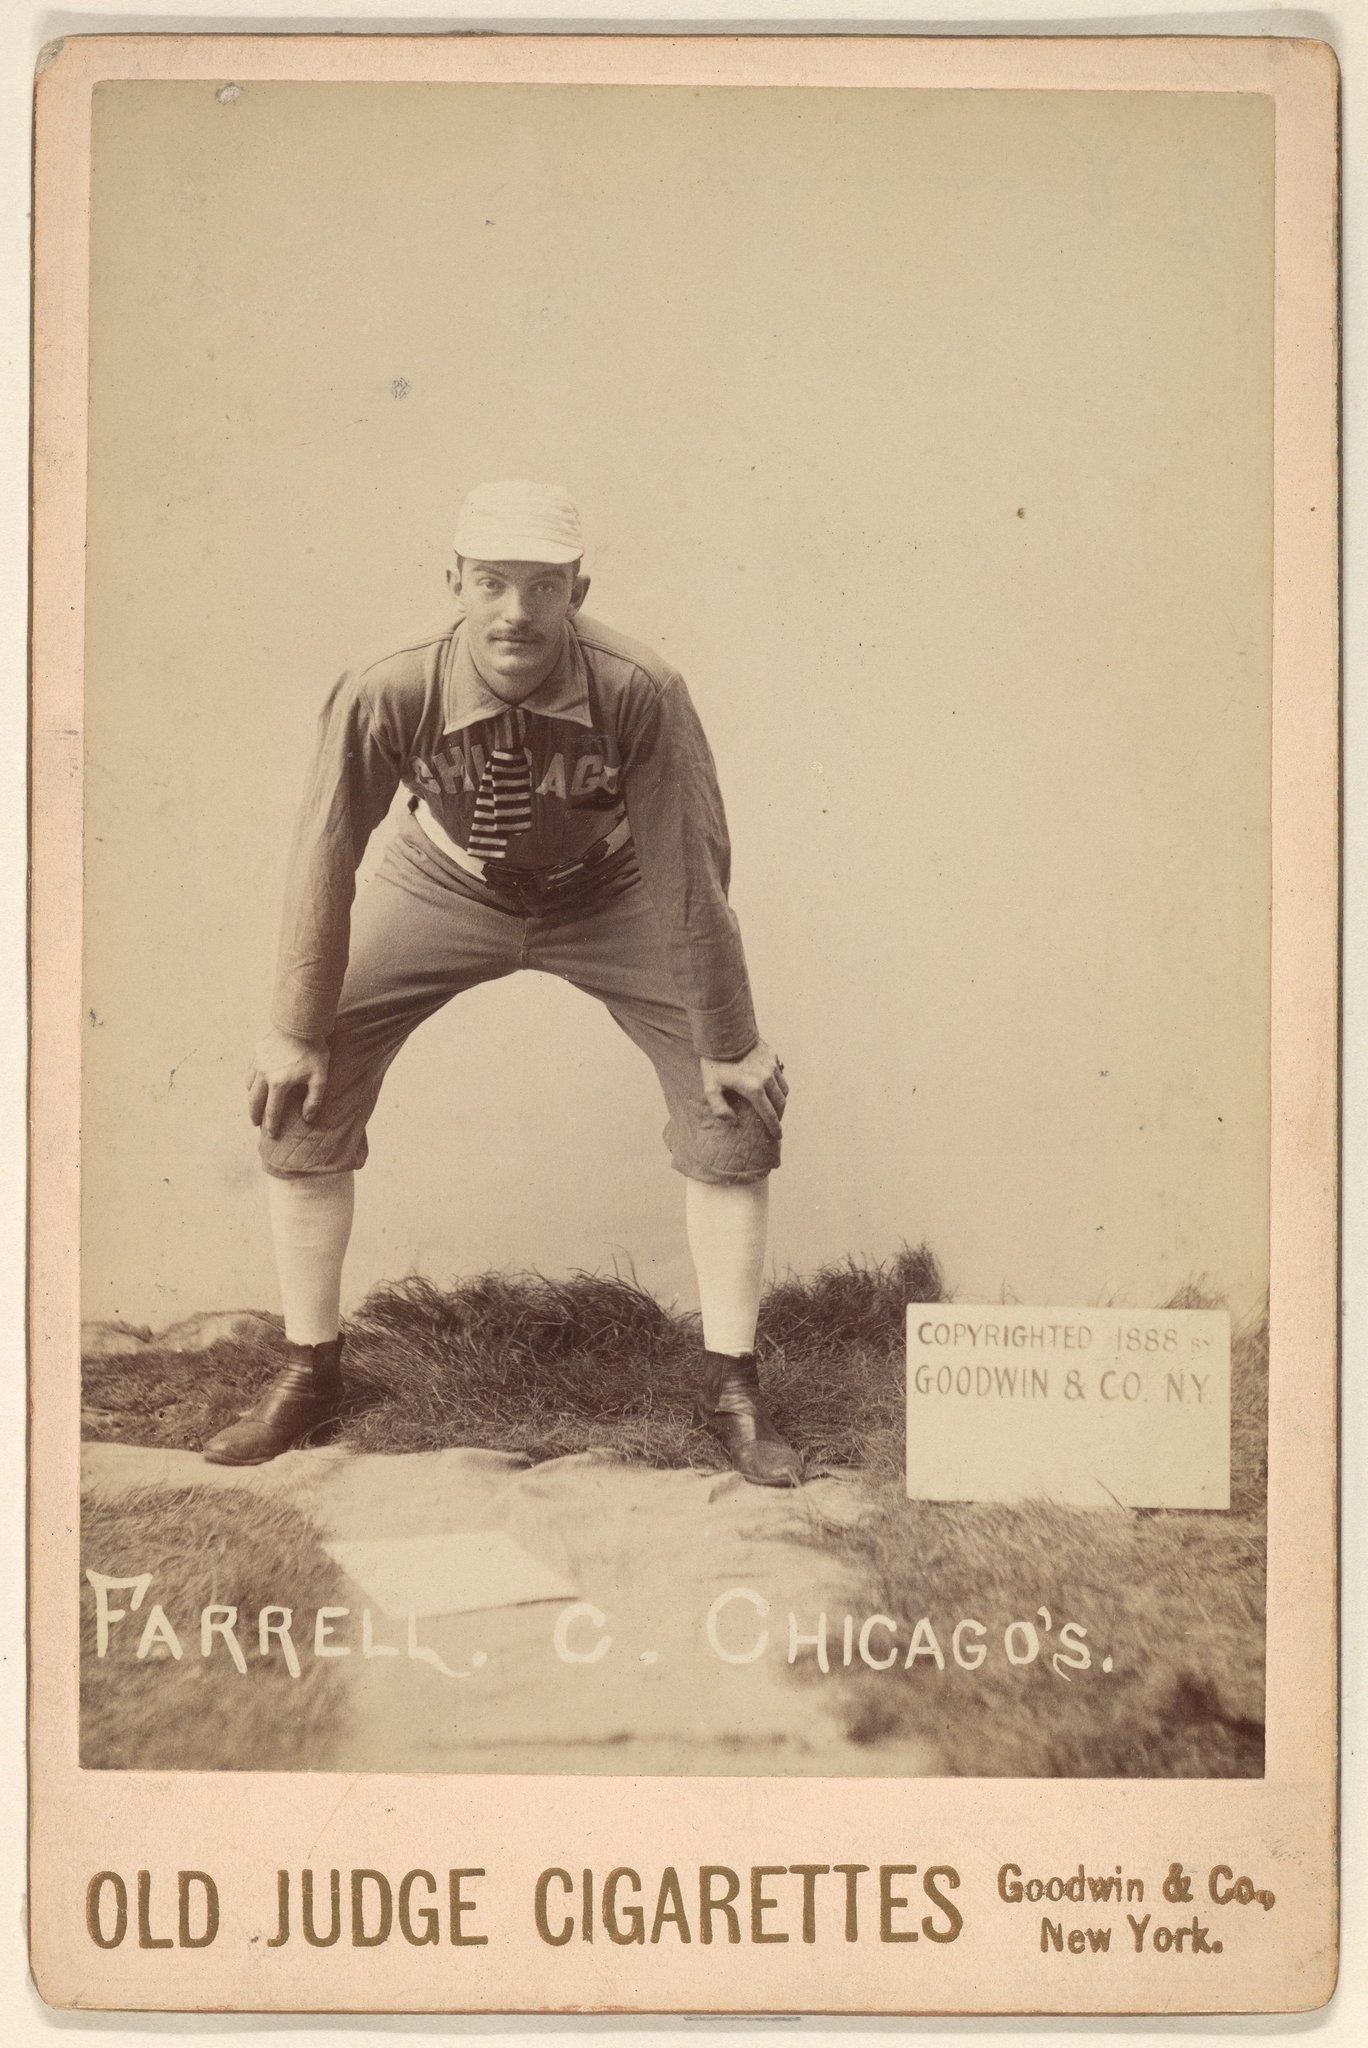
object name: baseball card, photograph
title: Charles Andrew Farrell, Catcher, Chicago, from the series Old Judge Cigarettes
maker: goodwin & company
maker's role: publisher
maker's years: 1850-1950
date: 1888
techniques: albumen silver print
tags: men,portraits,baseball,athletes